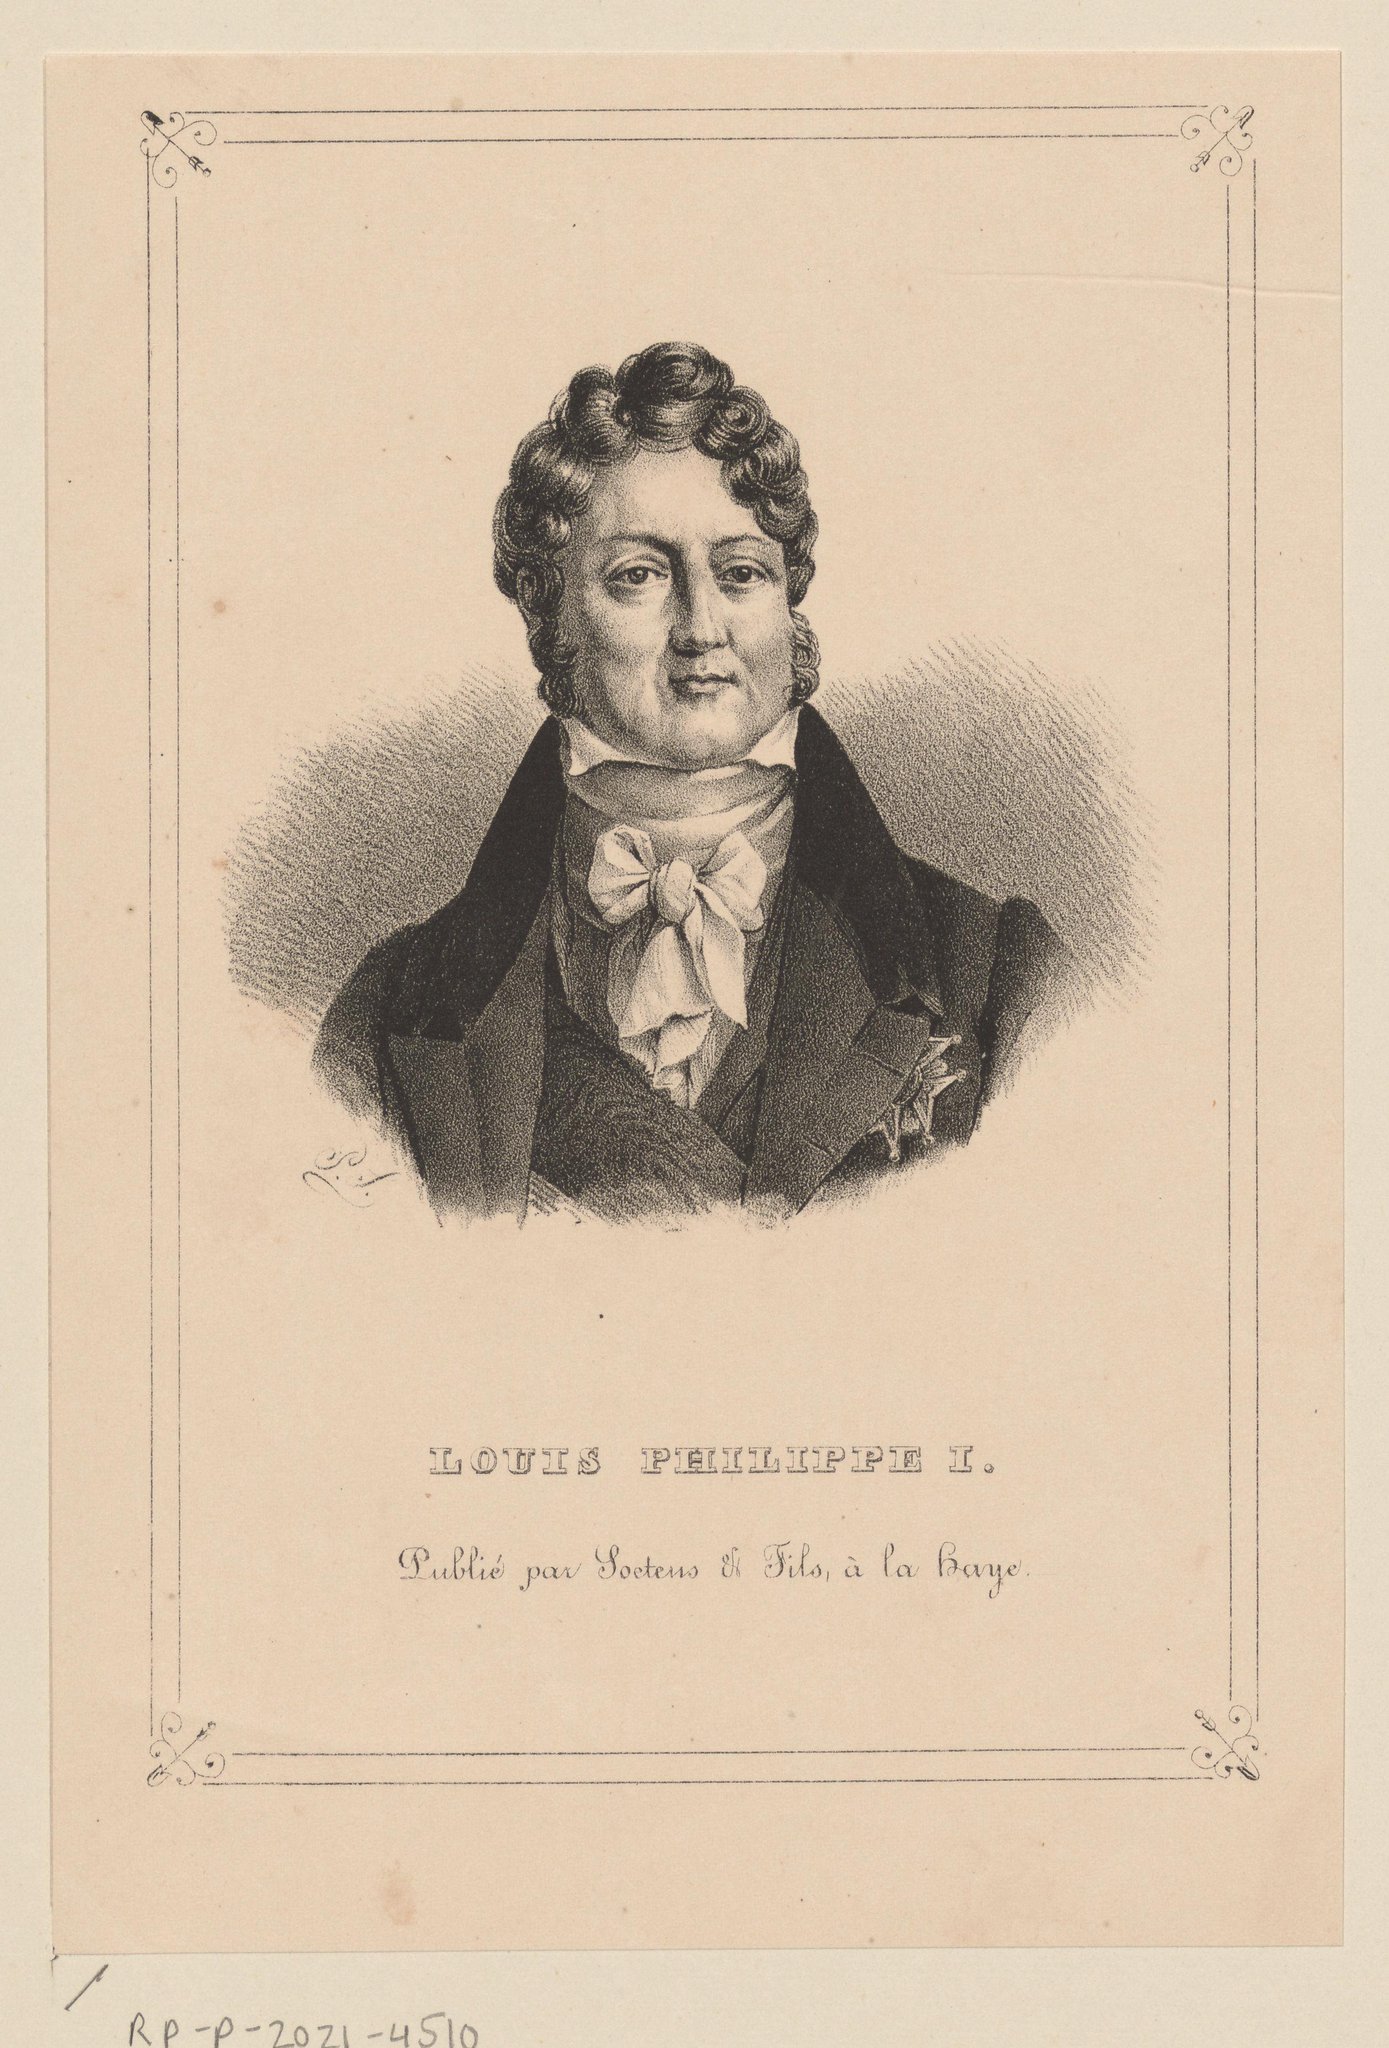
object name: print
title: Portret van Lodewijk Filips I van Frankrijk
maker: Anonymous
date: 1837-1840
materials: paper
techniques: lithograph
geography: netherlands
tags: paris, lodewijk filips i (koning van frankrijk), historical persons, king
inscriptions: monogram: ‘P.S.’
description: Deze prent maakte deel uit van een serie uitgegeven door Soetens et Fils omstreeks 1838, opgedragen aan de Prins van Oranje. In de 'Prospectus en Inteekenlijst' stond vermeld dat het zal bestaan uit een onbepaald aantal portretten, waarvan er drie of vier per maand verschijnen. Zie Van Someren.